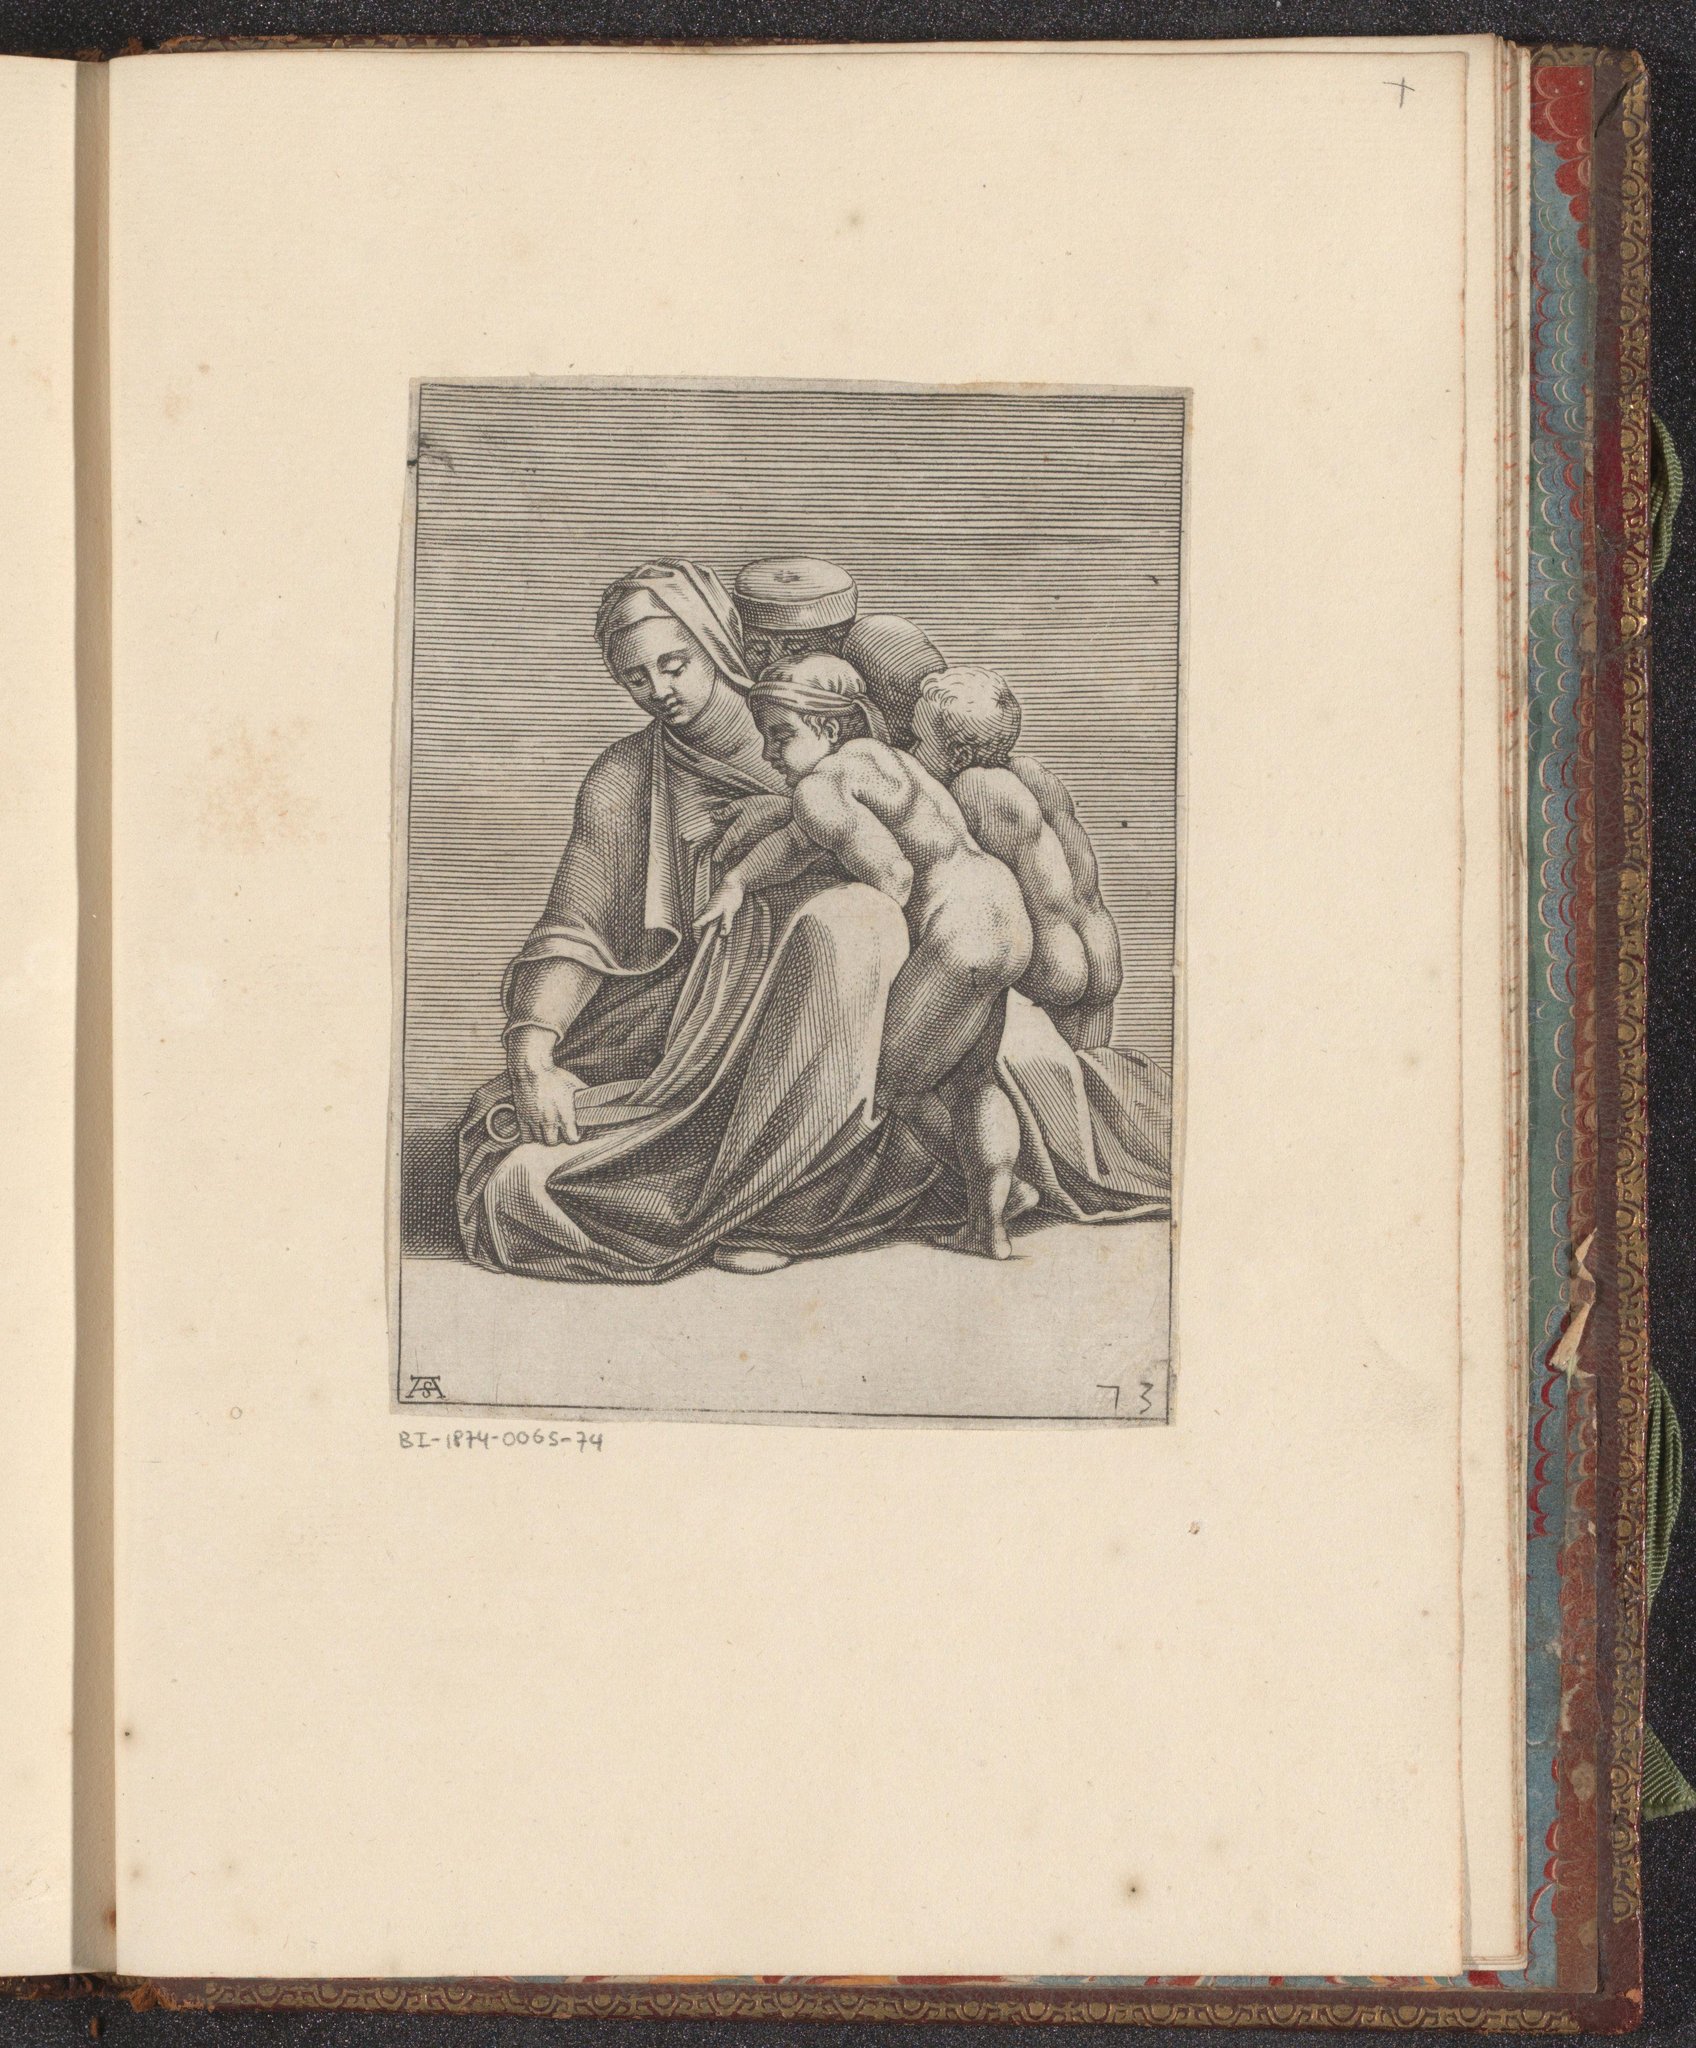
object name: album leaf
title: albumblad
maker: adamo scultori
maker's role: painter, print maker, sculptor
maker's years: 1530-1585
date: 1585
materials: paper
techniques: engraving, intaglio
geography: vatican city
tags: tools, aids, implements ~ crafts and industries: scissors, mother and child(ren), woman and child(ren) (family group)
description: Zittende vrouw met een schaar in de hand. Naast haar een man en naakte kinderen. Figuurgroep uit Michelangelo's plafondschildering. Genummerd rechtsonder: 73. De prent maakt deel uit van een album.